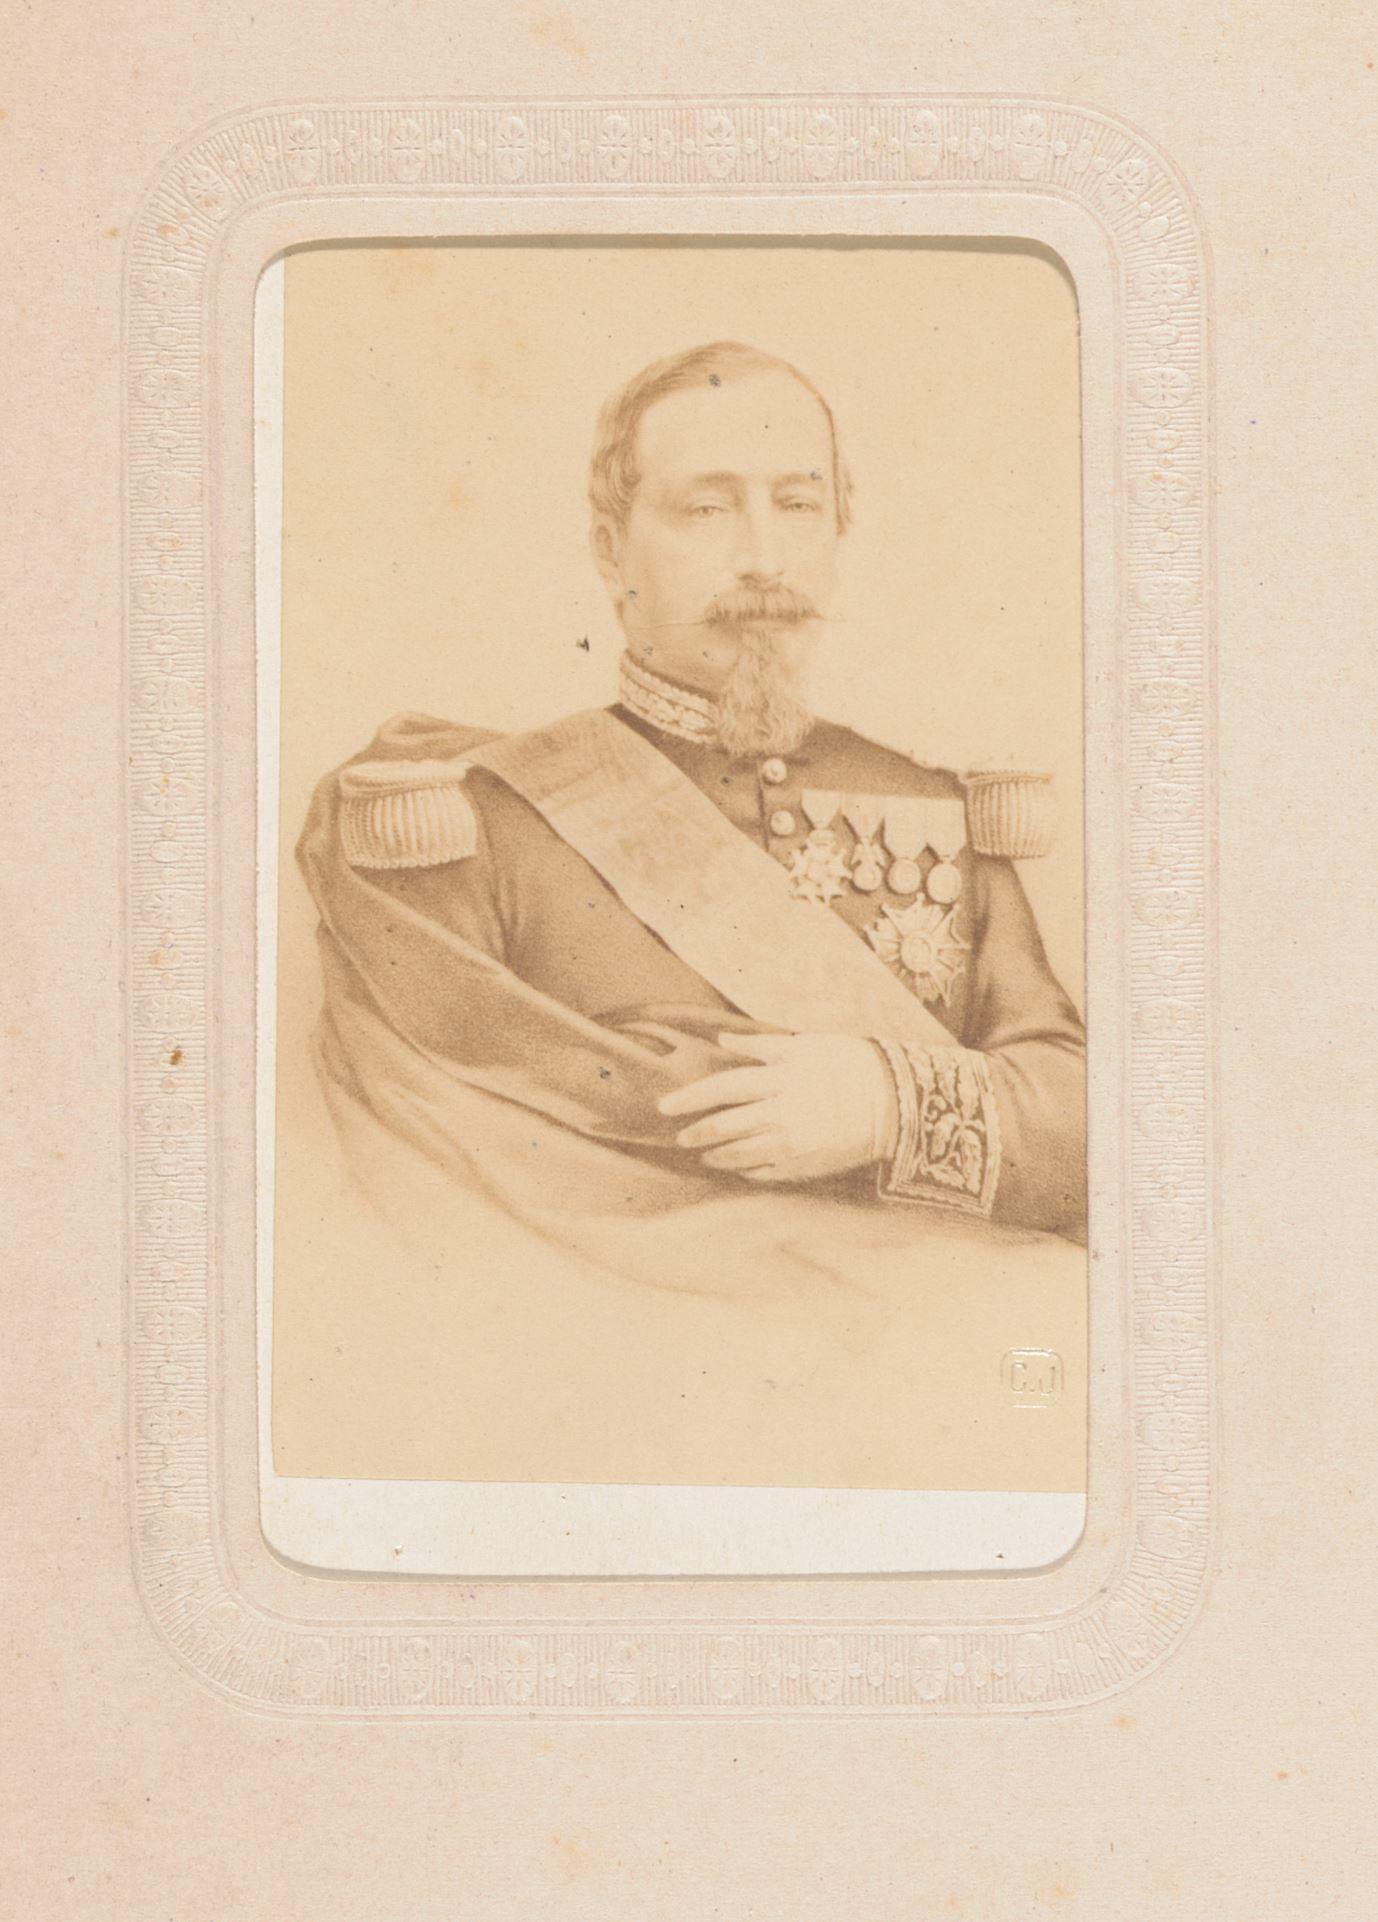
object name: carte de visite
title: Fotoreproductie van een portret van een man in militair uniform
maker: Anonymous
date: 1855-1865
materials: cardboard, photographic support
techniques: albumen print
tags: historical persons, (military) uniforms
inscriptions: monogram: ‘C.J’